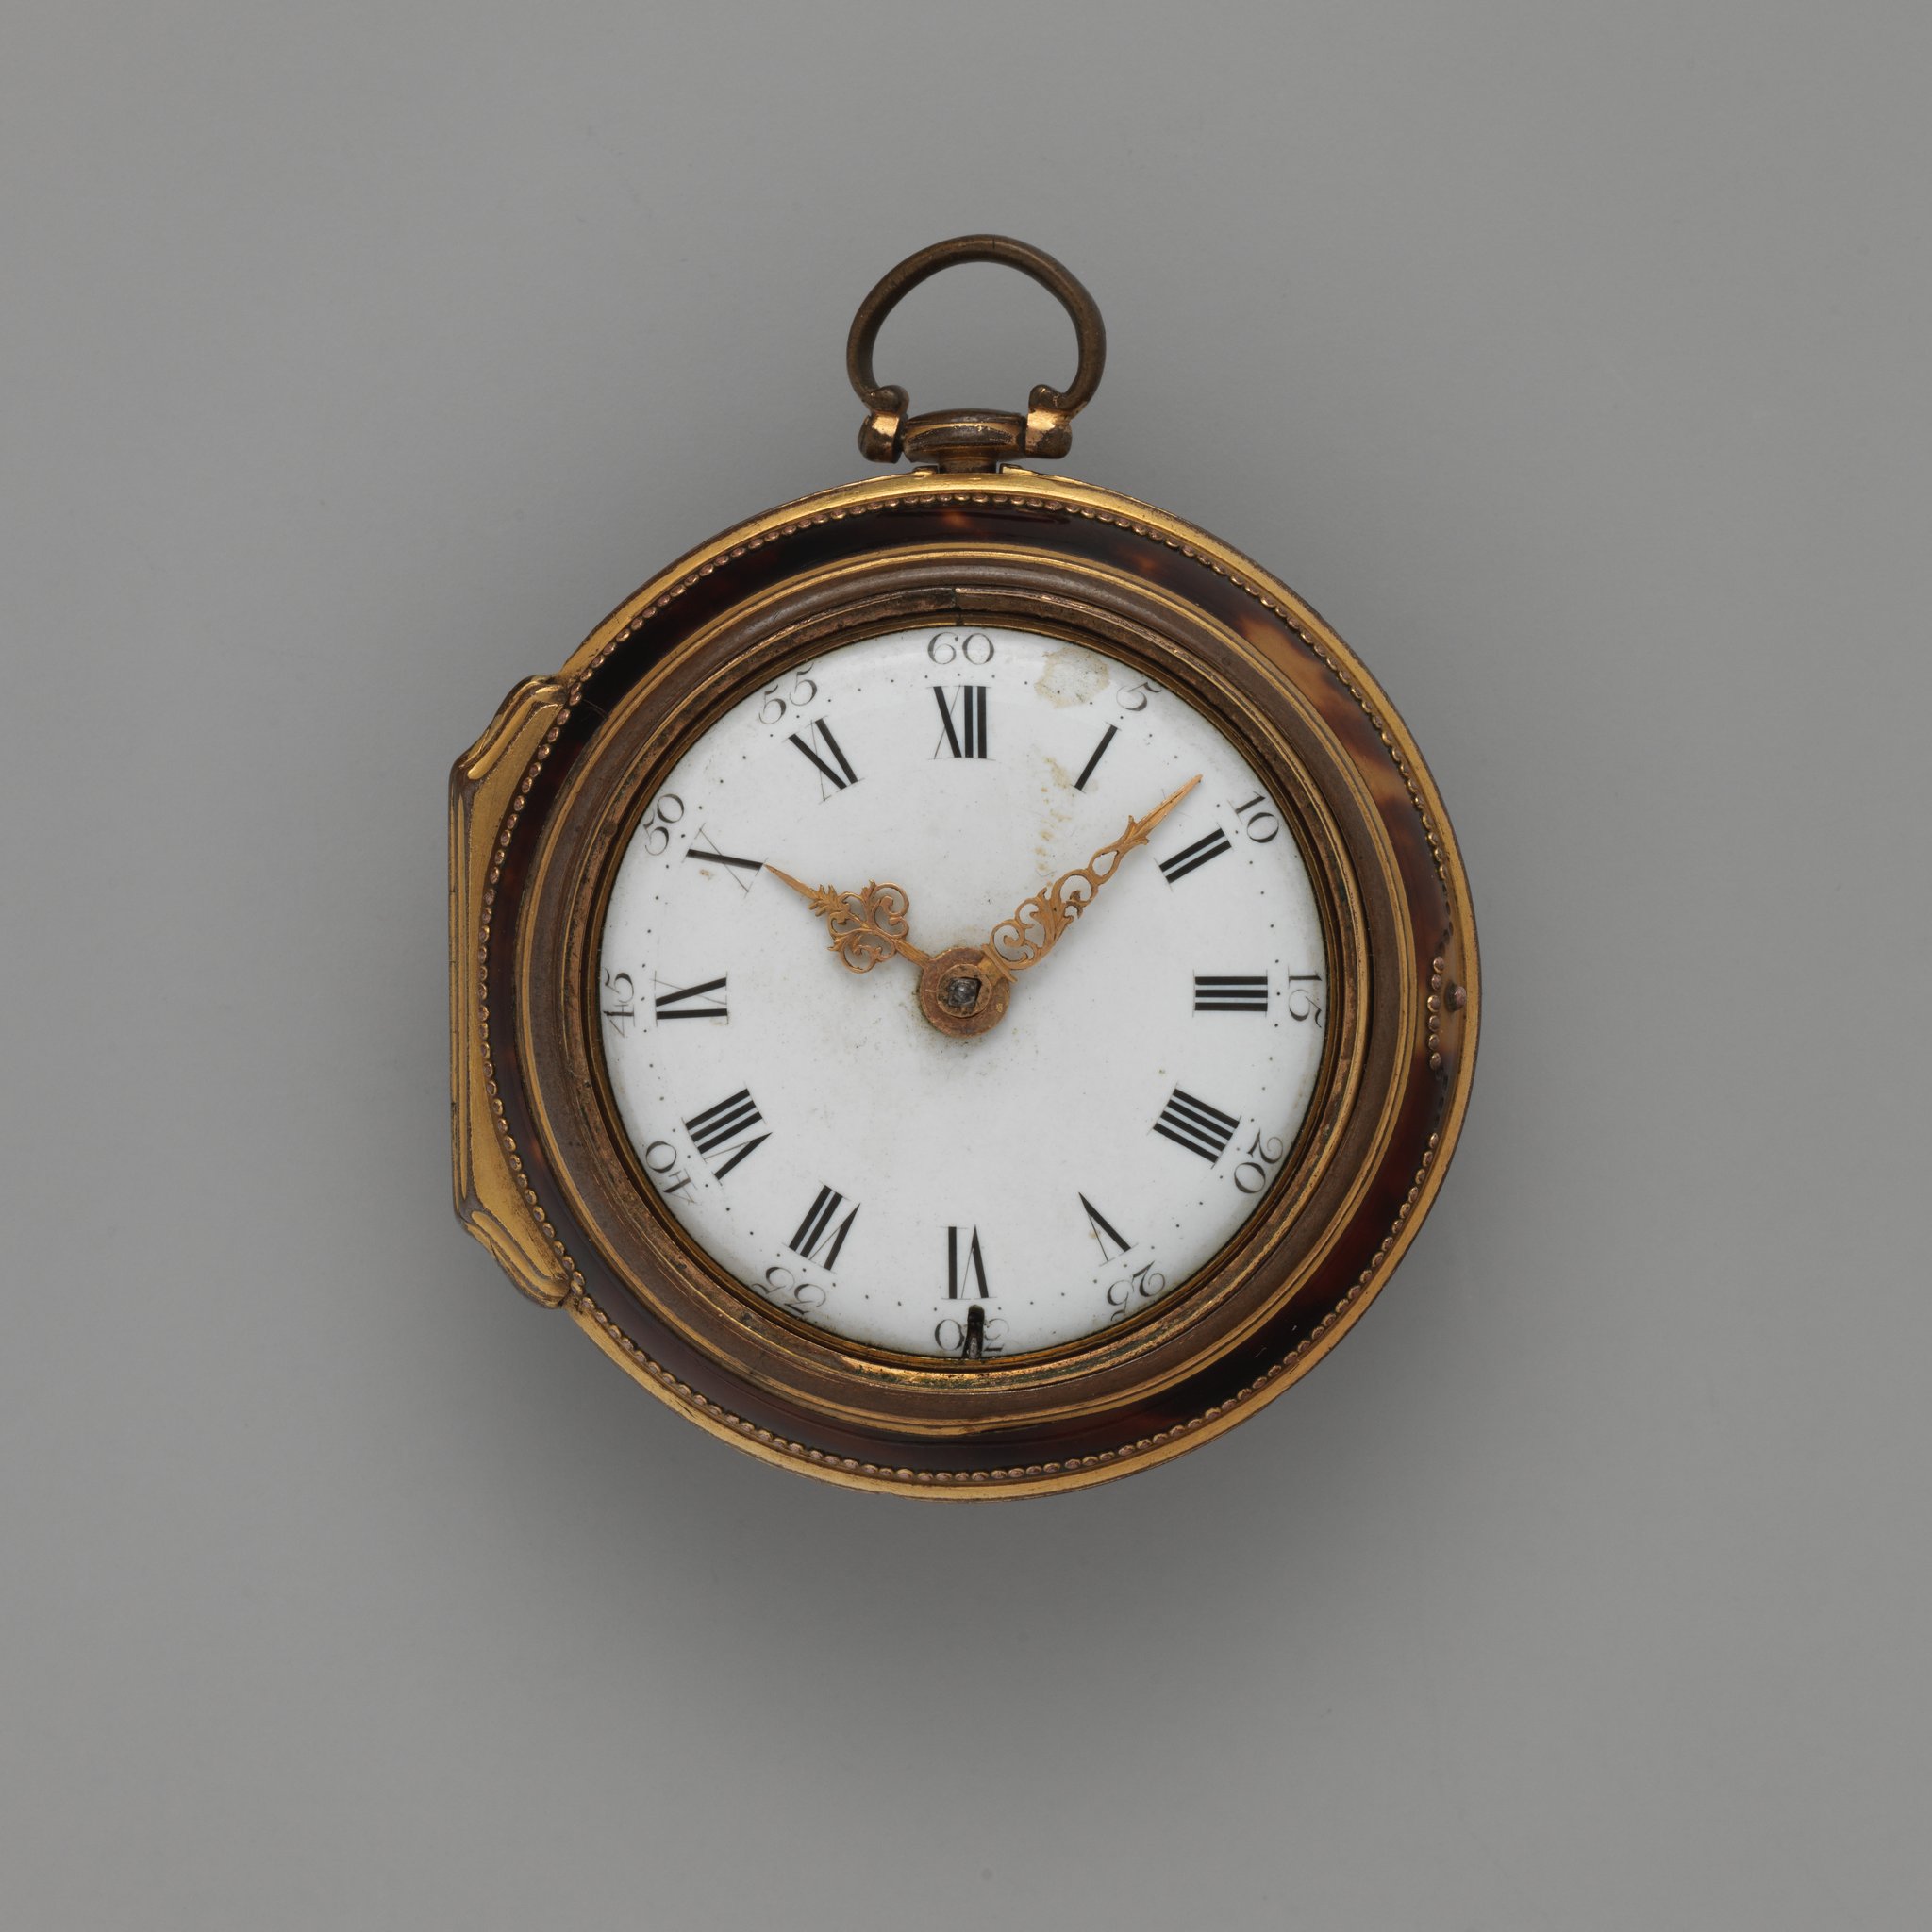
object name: watch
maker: isaac rogers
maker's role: maker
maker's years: 1700-1800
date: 1701-1800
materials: enamel, shell